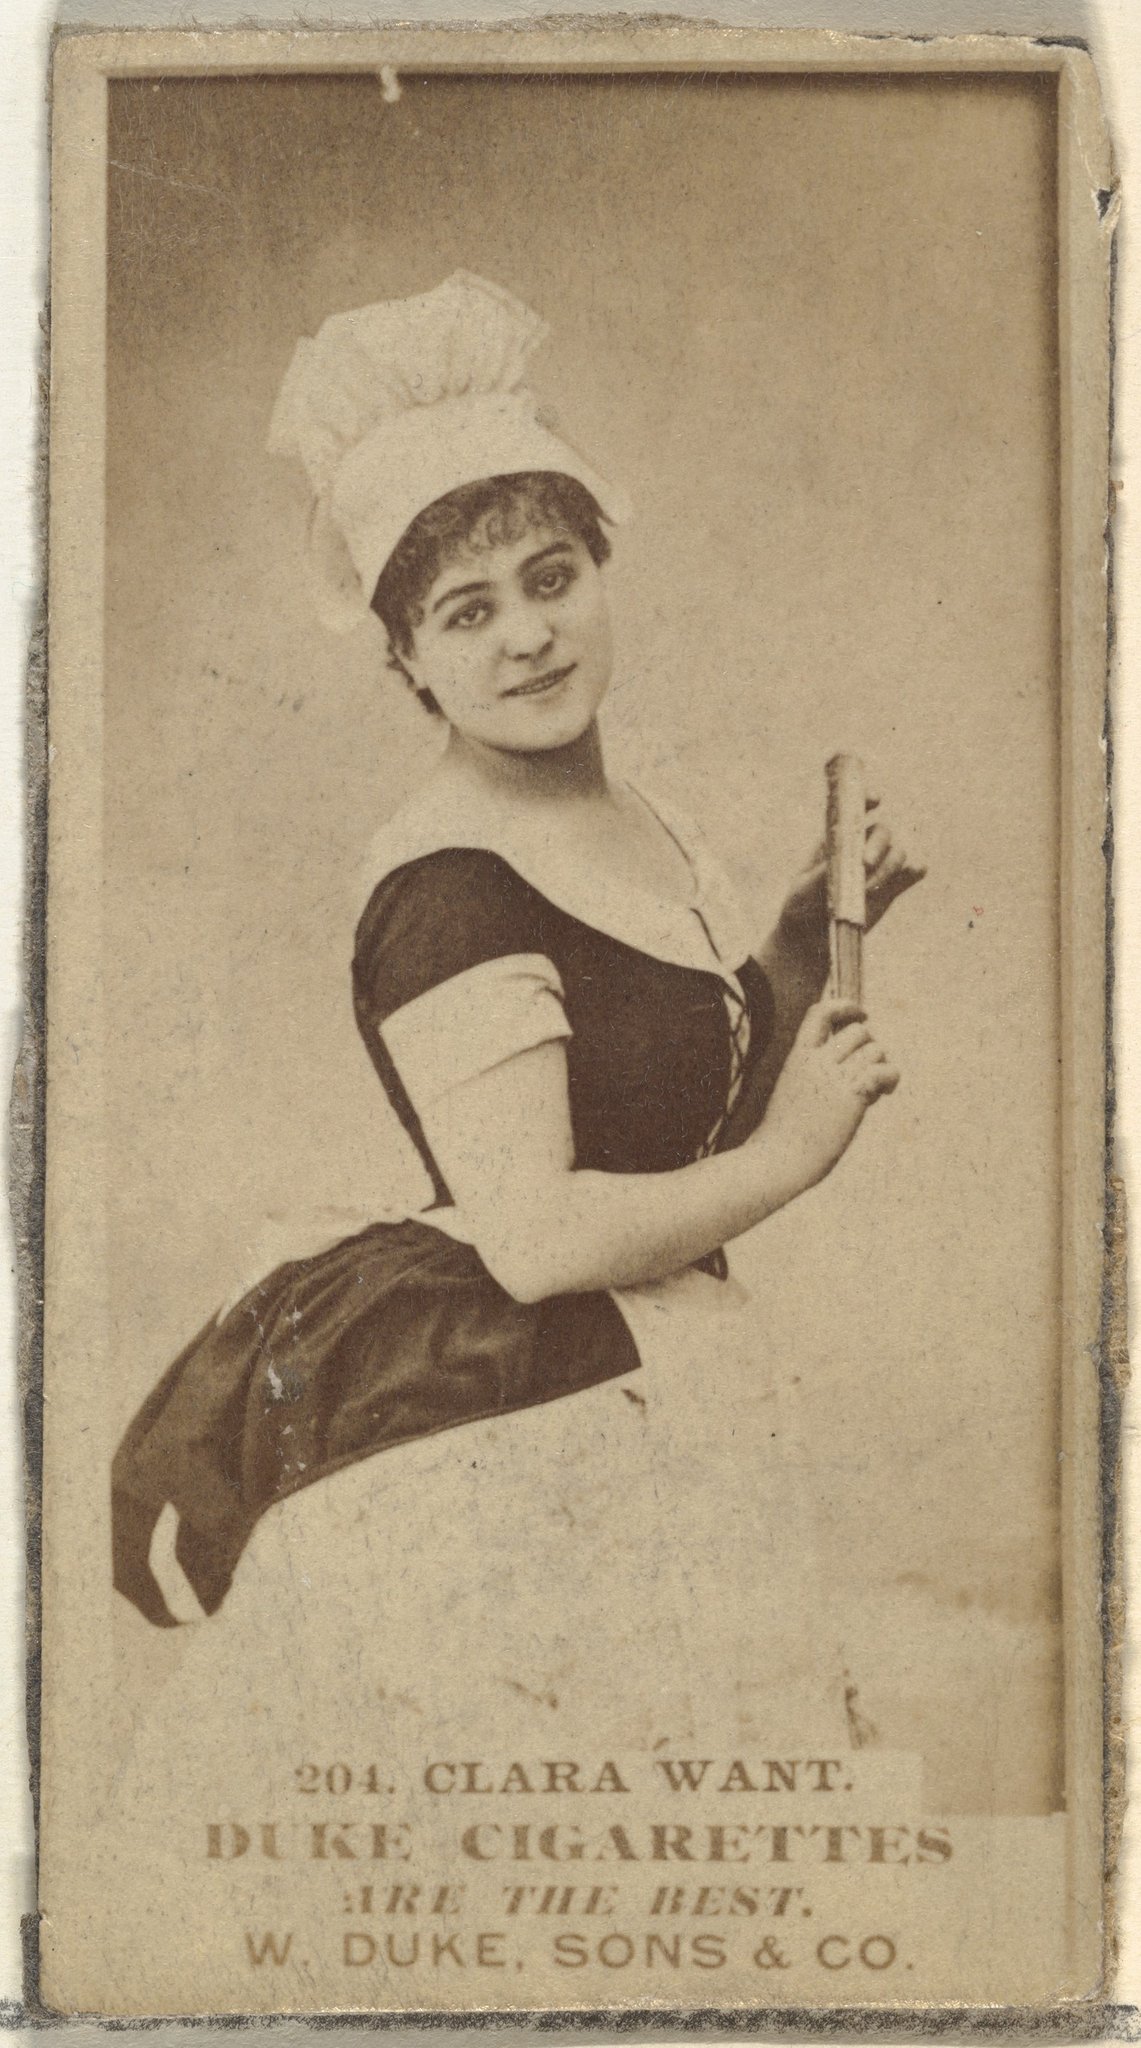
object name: photograph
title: Card Number 204, Clara Want, from the Actors and Actresses series (N145-7) issued by Duke Sons & Co. to promote Duke Cigarettes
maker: w. duke, sons & co.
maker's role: publisher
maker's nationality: american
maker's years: 1870-1920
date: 1880-1889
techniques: albumen silver print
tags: portraits,women,actresses